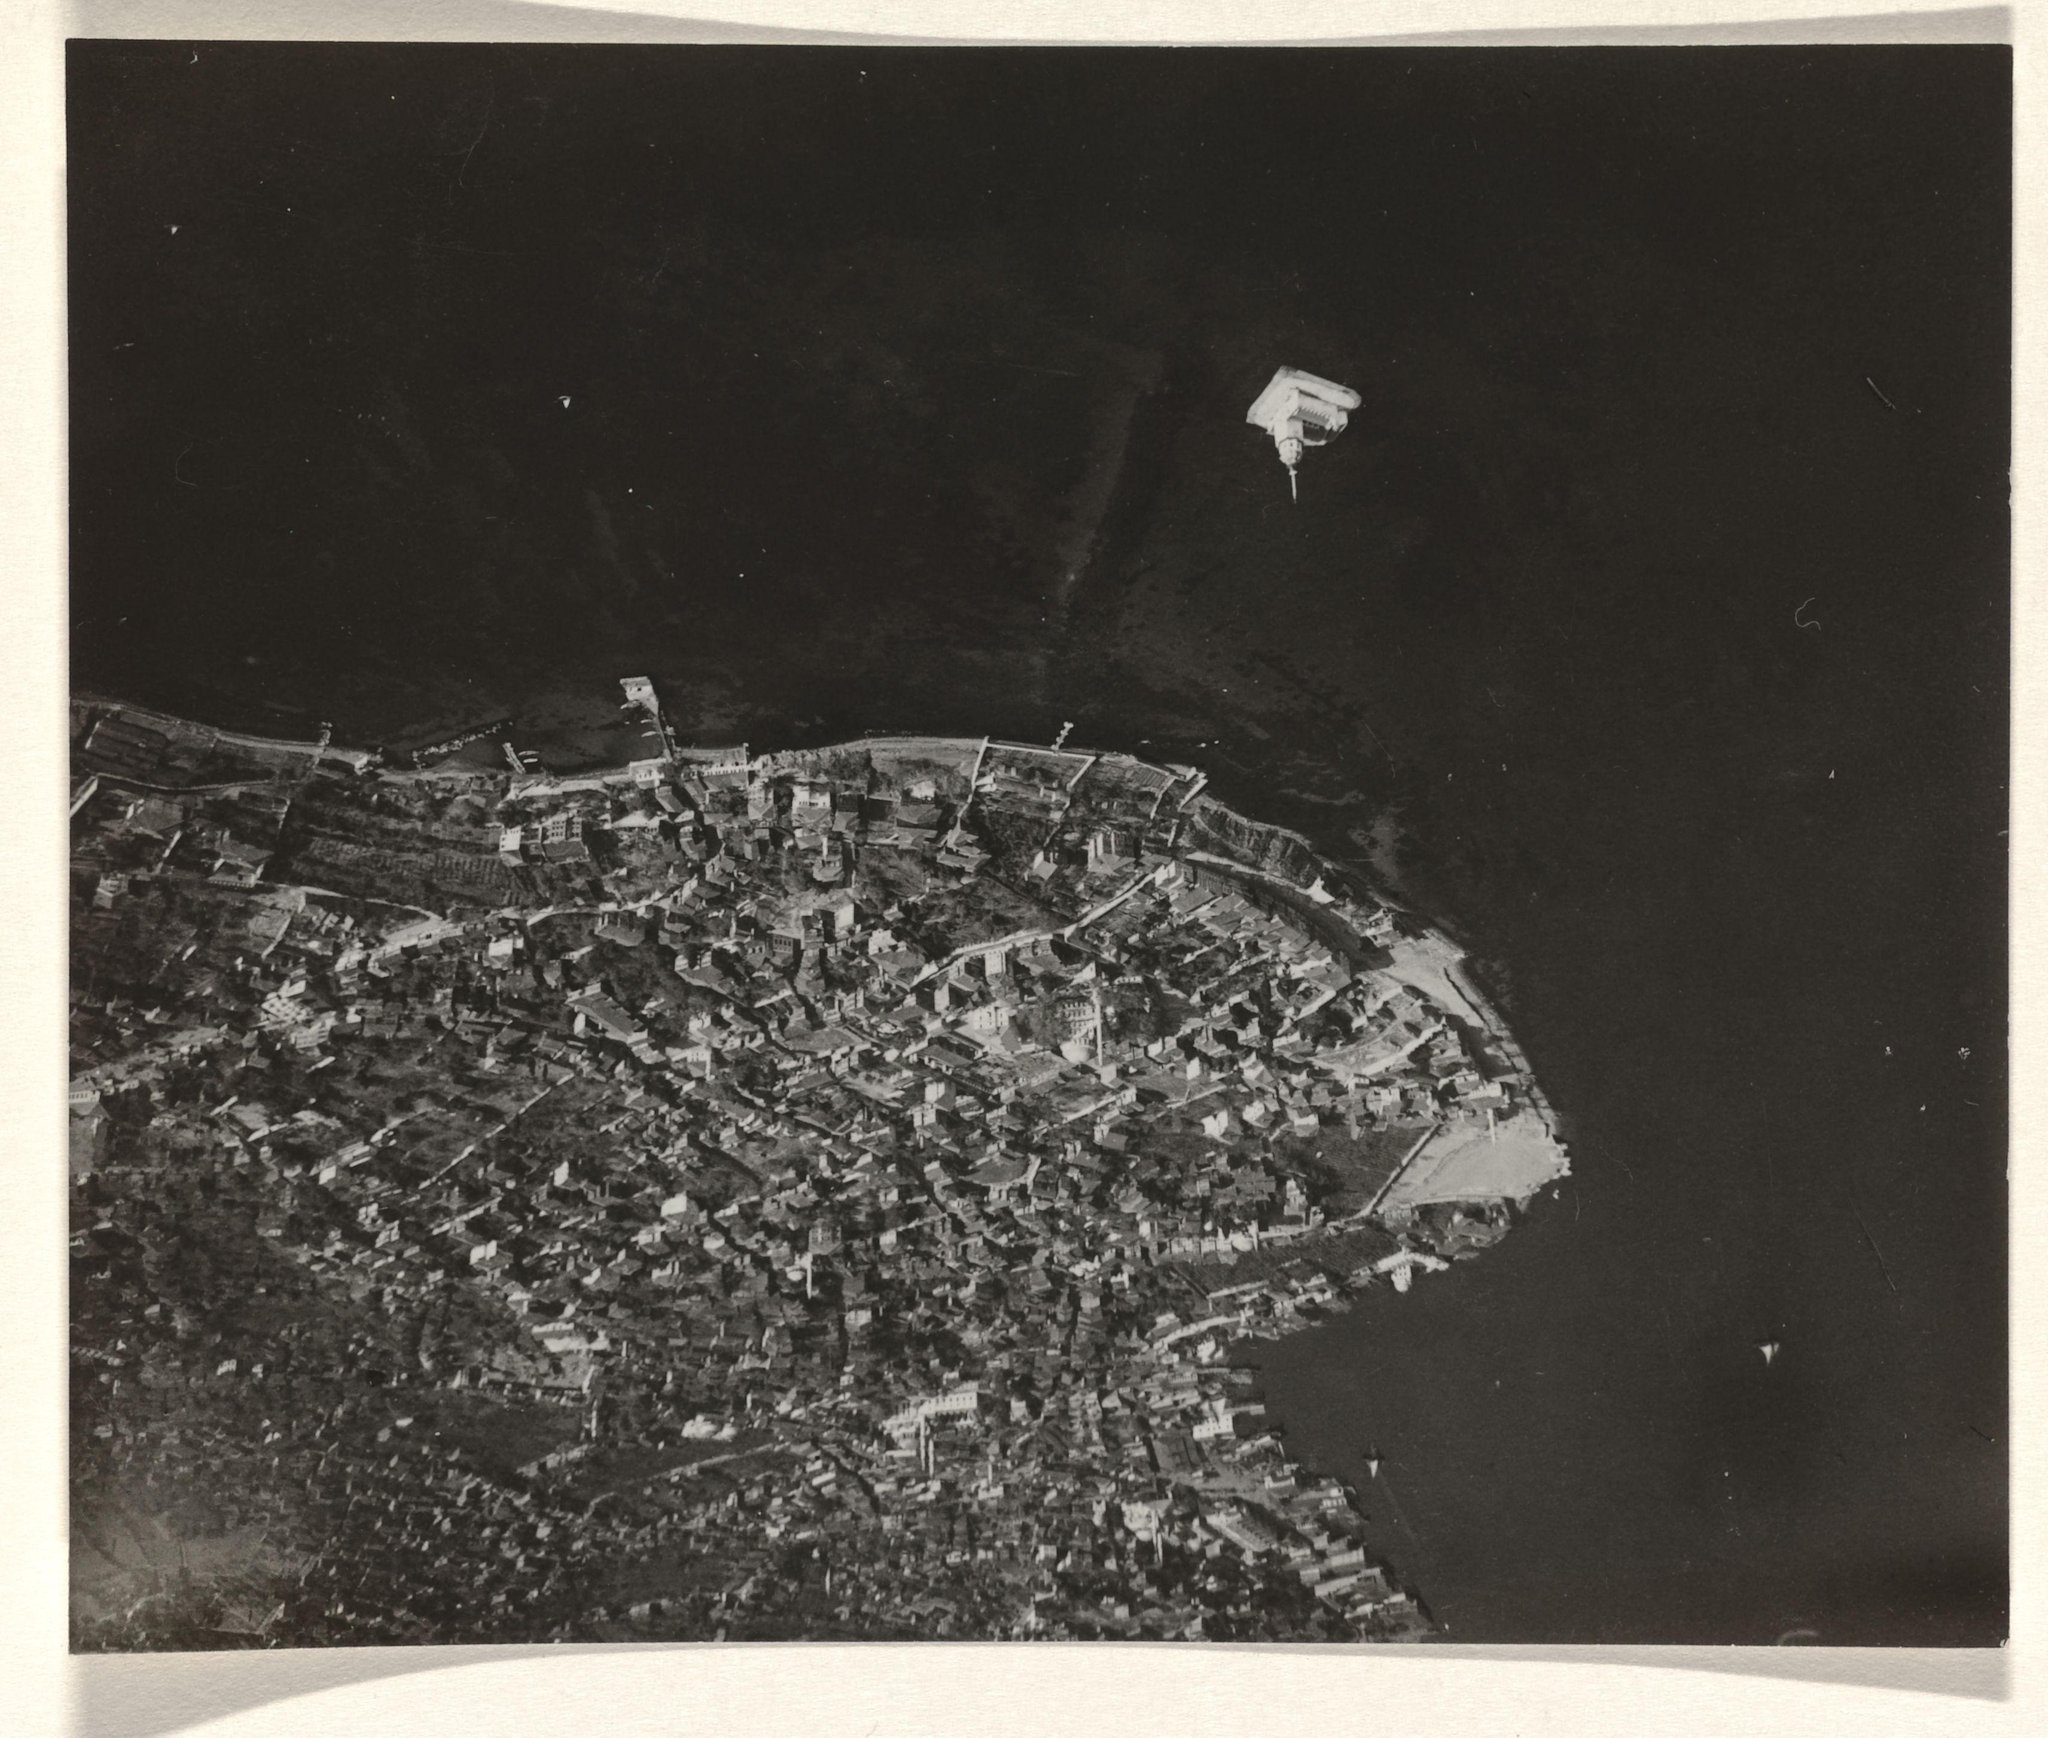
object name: photograph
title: Luchtfoto in zwart-wit van een stad of dorp, gelegen aan het water, met een schiereiland en installatie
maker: Anonymous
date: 1930-1975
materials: photographic support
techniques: gelatin silver print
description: Luchtfoto in zwart-wit van een stad of dorp, gelegen aan het water, met een schiereiland en installatie(links, midden).